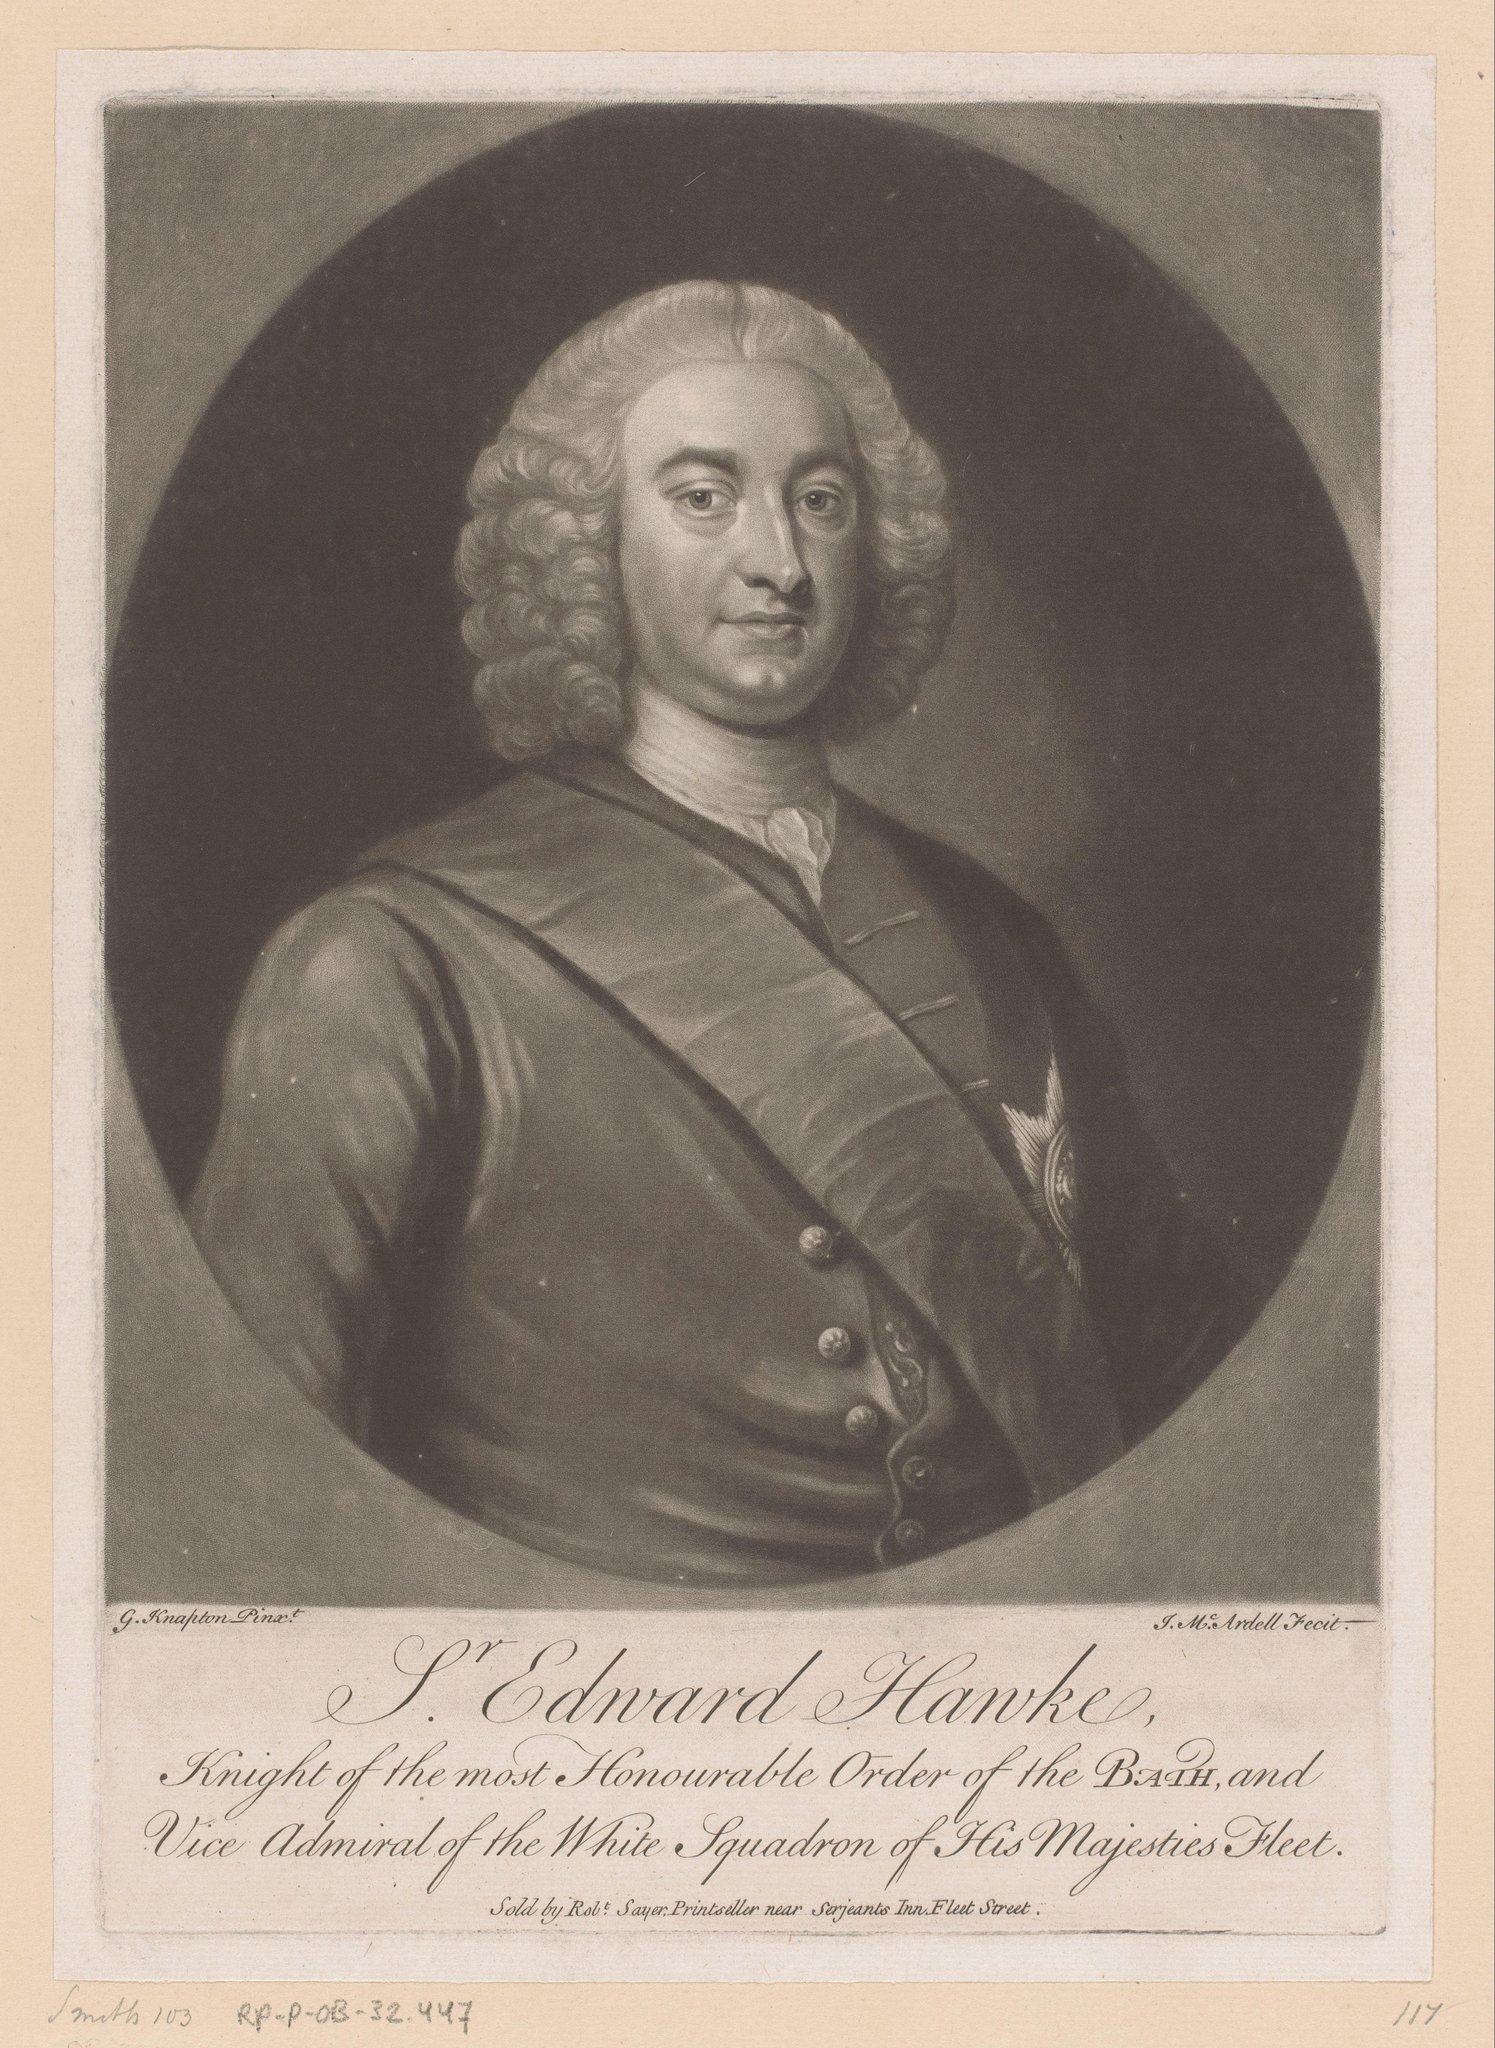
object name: print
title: Sr. Edward Hawke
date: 1747-1765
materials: paper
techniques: mezzotint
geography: london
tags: edward hawke (1e baron hawke), historical persons, commander-in-chief, admiral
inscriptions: collector's mark: Lugt 240